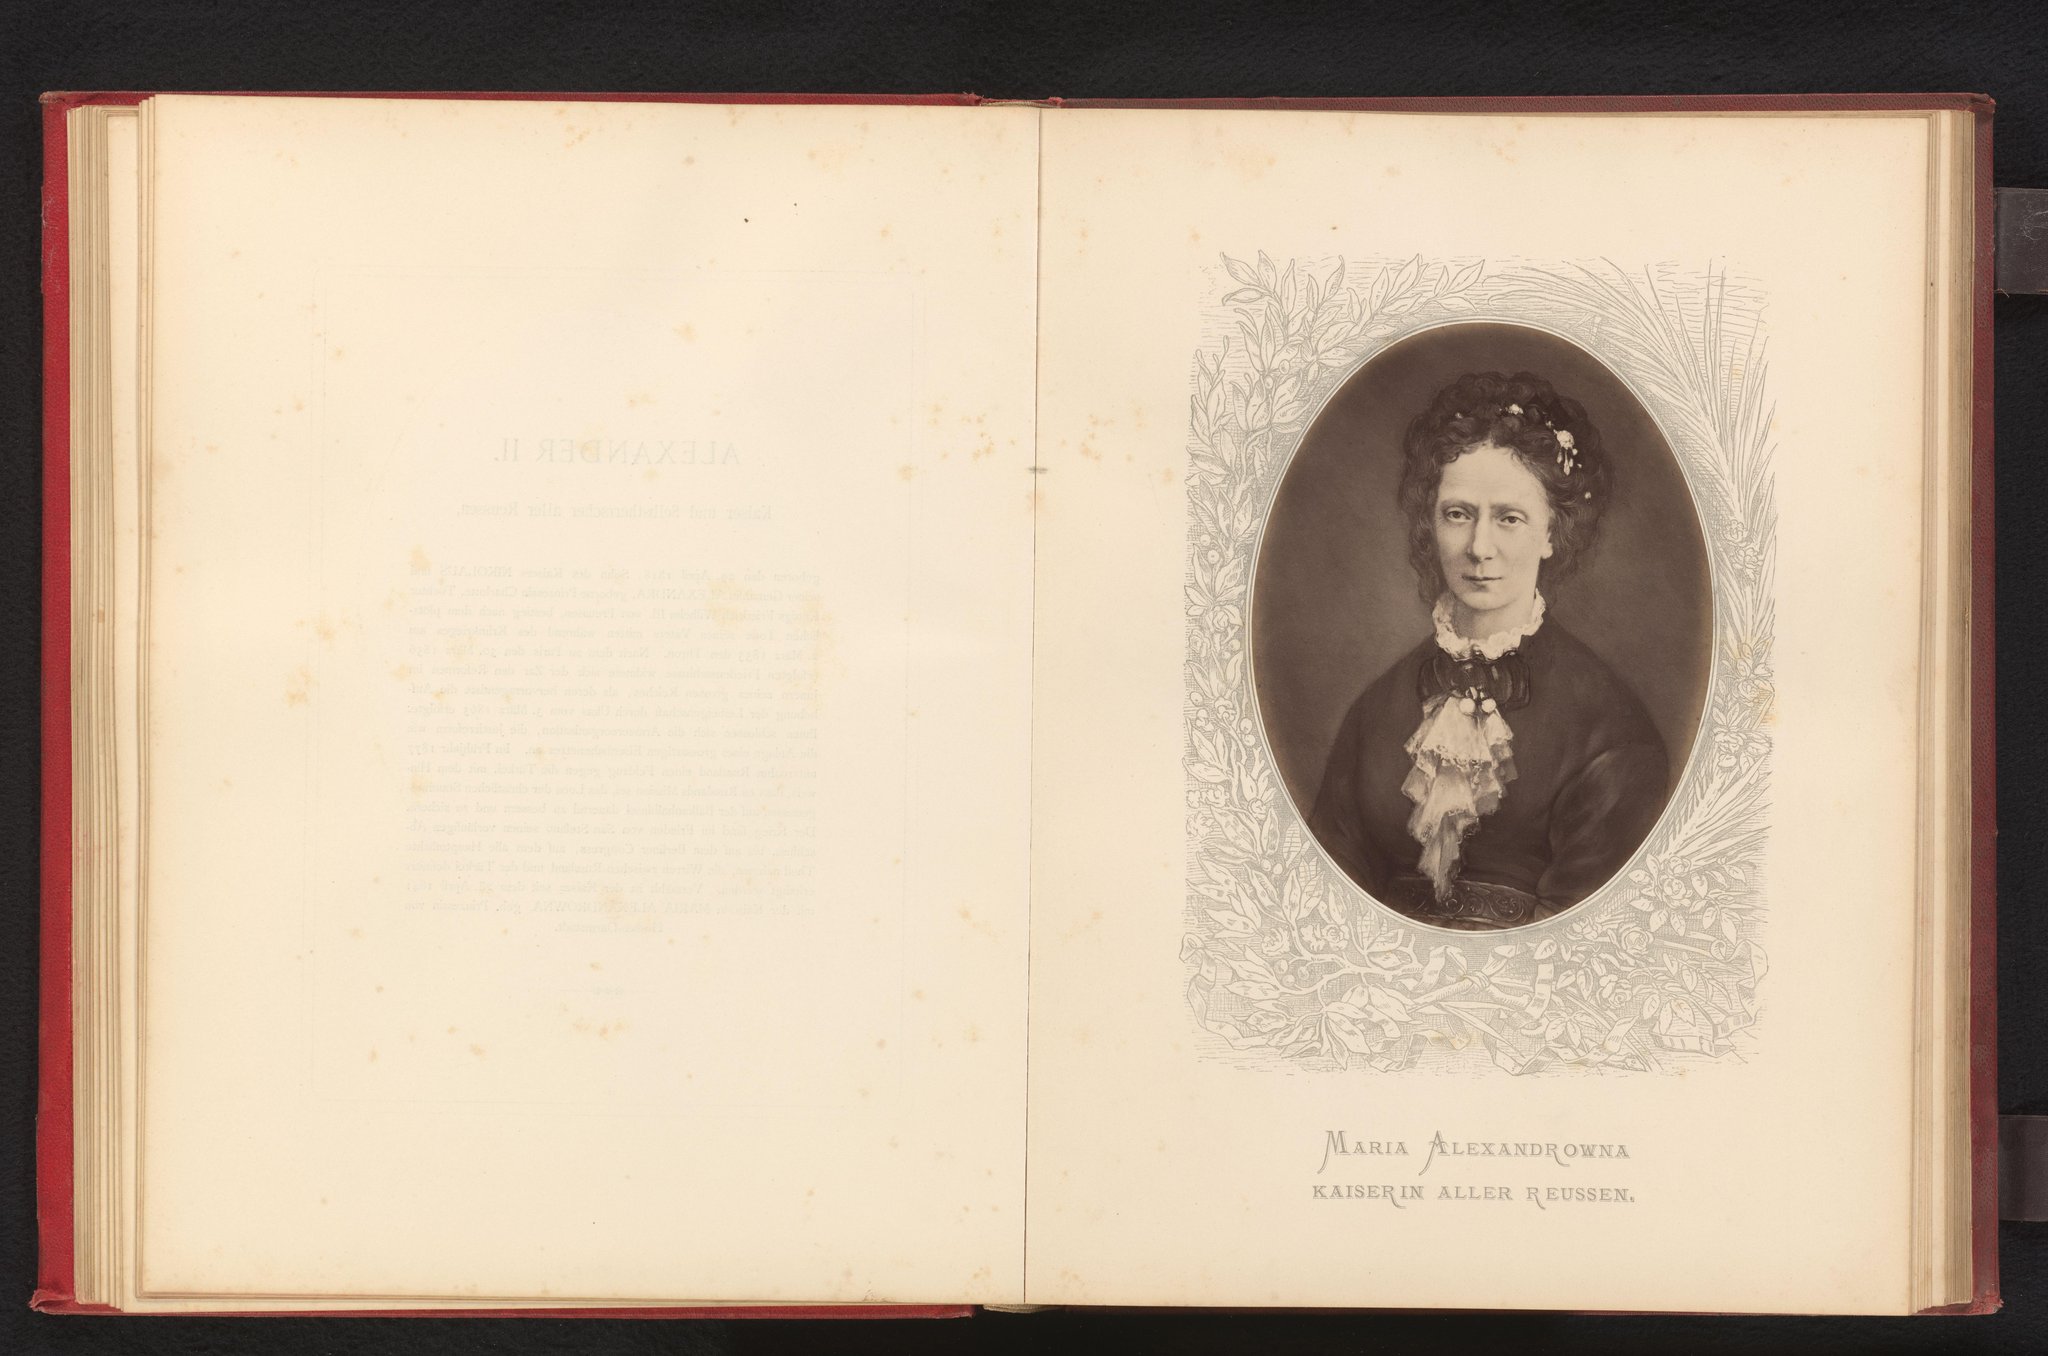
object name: reproduction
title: Maria Alexandrowna, Kaiserin aller Reussen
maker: Anonymous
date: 1875-1880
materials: paper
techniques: albumen print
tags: historical persons - bb - woman, queen, empress, etc. (wife of a ruler)